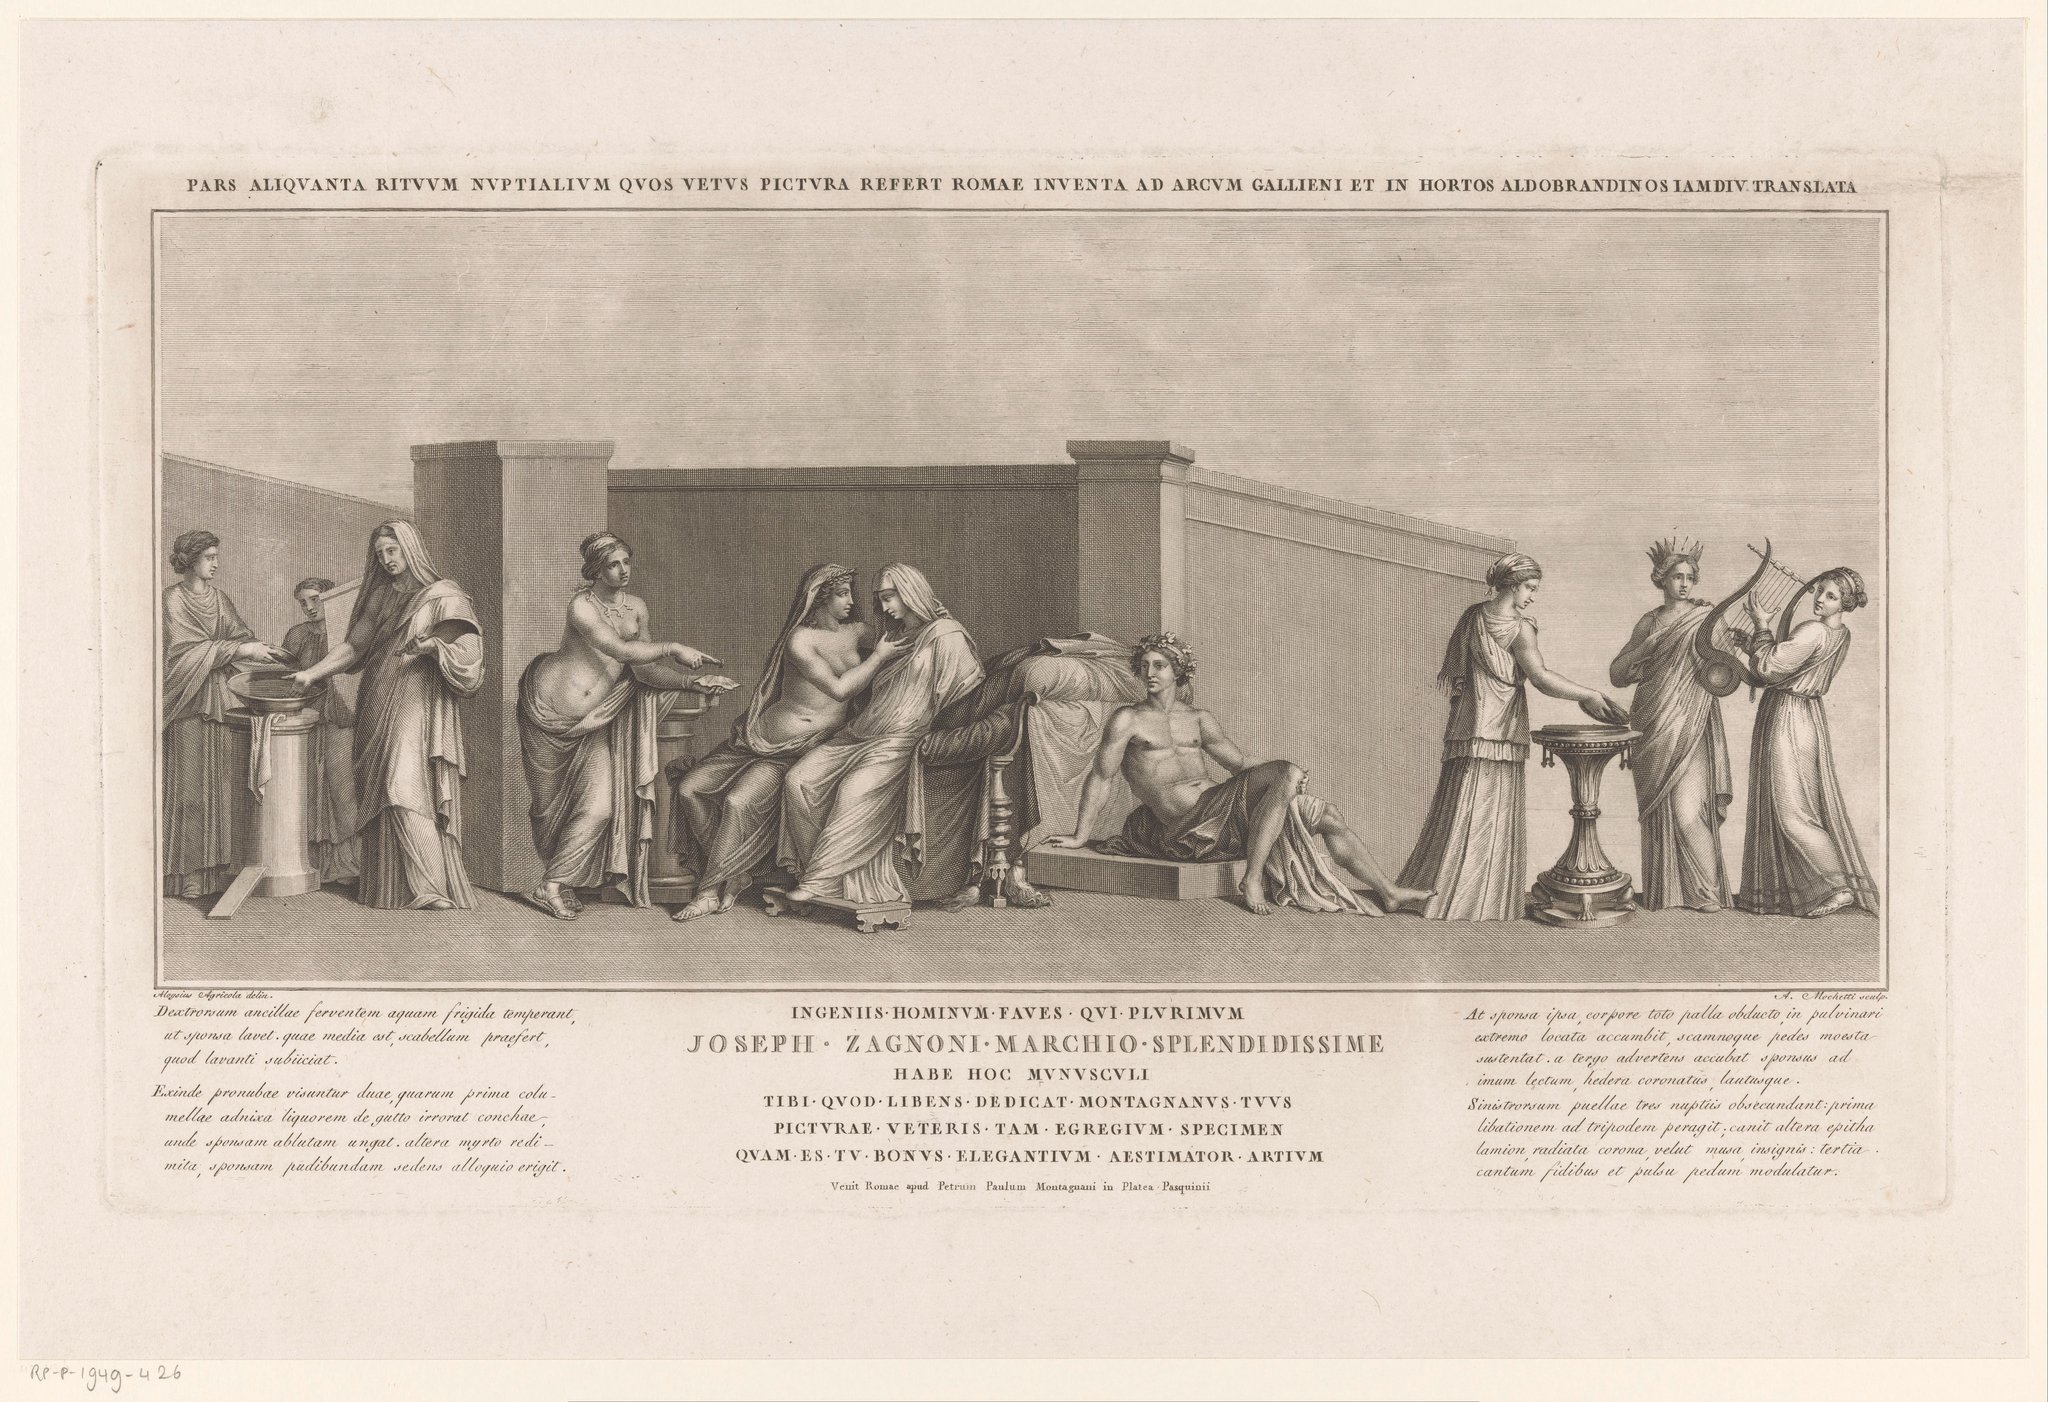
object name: print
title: Aldobrandinische bruiloft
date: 1770-1830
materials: paper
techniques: engraving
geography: italy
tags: wedding feast, wedding meal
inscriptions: collector's mark: Lugt 2228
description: Een muurschildering uit de Augusteïsche tijd die circa 1606 op de Esquilijn te Rome teruggevonden werd. Het beeldt in drie taferelen de toebereidselen tot een bruiloft uit. Links staat een vrouw die badwater in gereedheid brengt. In het midden zit een gesluierde bruid op een bed. Naast haar twee halfnaakte vrouwenfiguren (Peitho of Aphrodite en Charis) en een bekranste jongeman (Hymenaeus of de bruidegom). Rechts staan drie vrouwen, van wie er een reukwater uitgiet, een tweede op een lier speelt en een derde de leiding van de ceremonie heeft. Titel boven voorstelling. Tekst en opdracht in het Latijn in ondermarge.